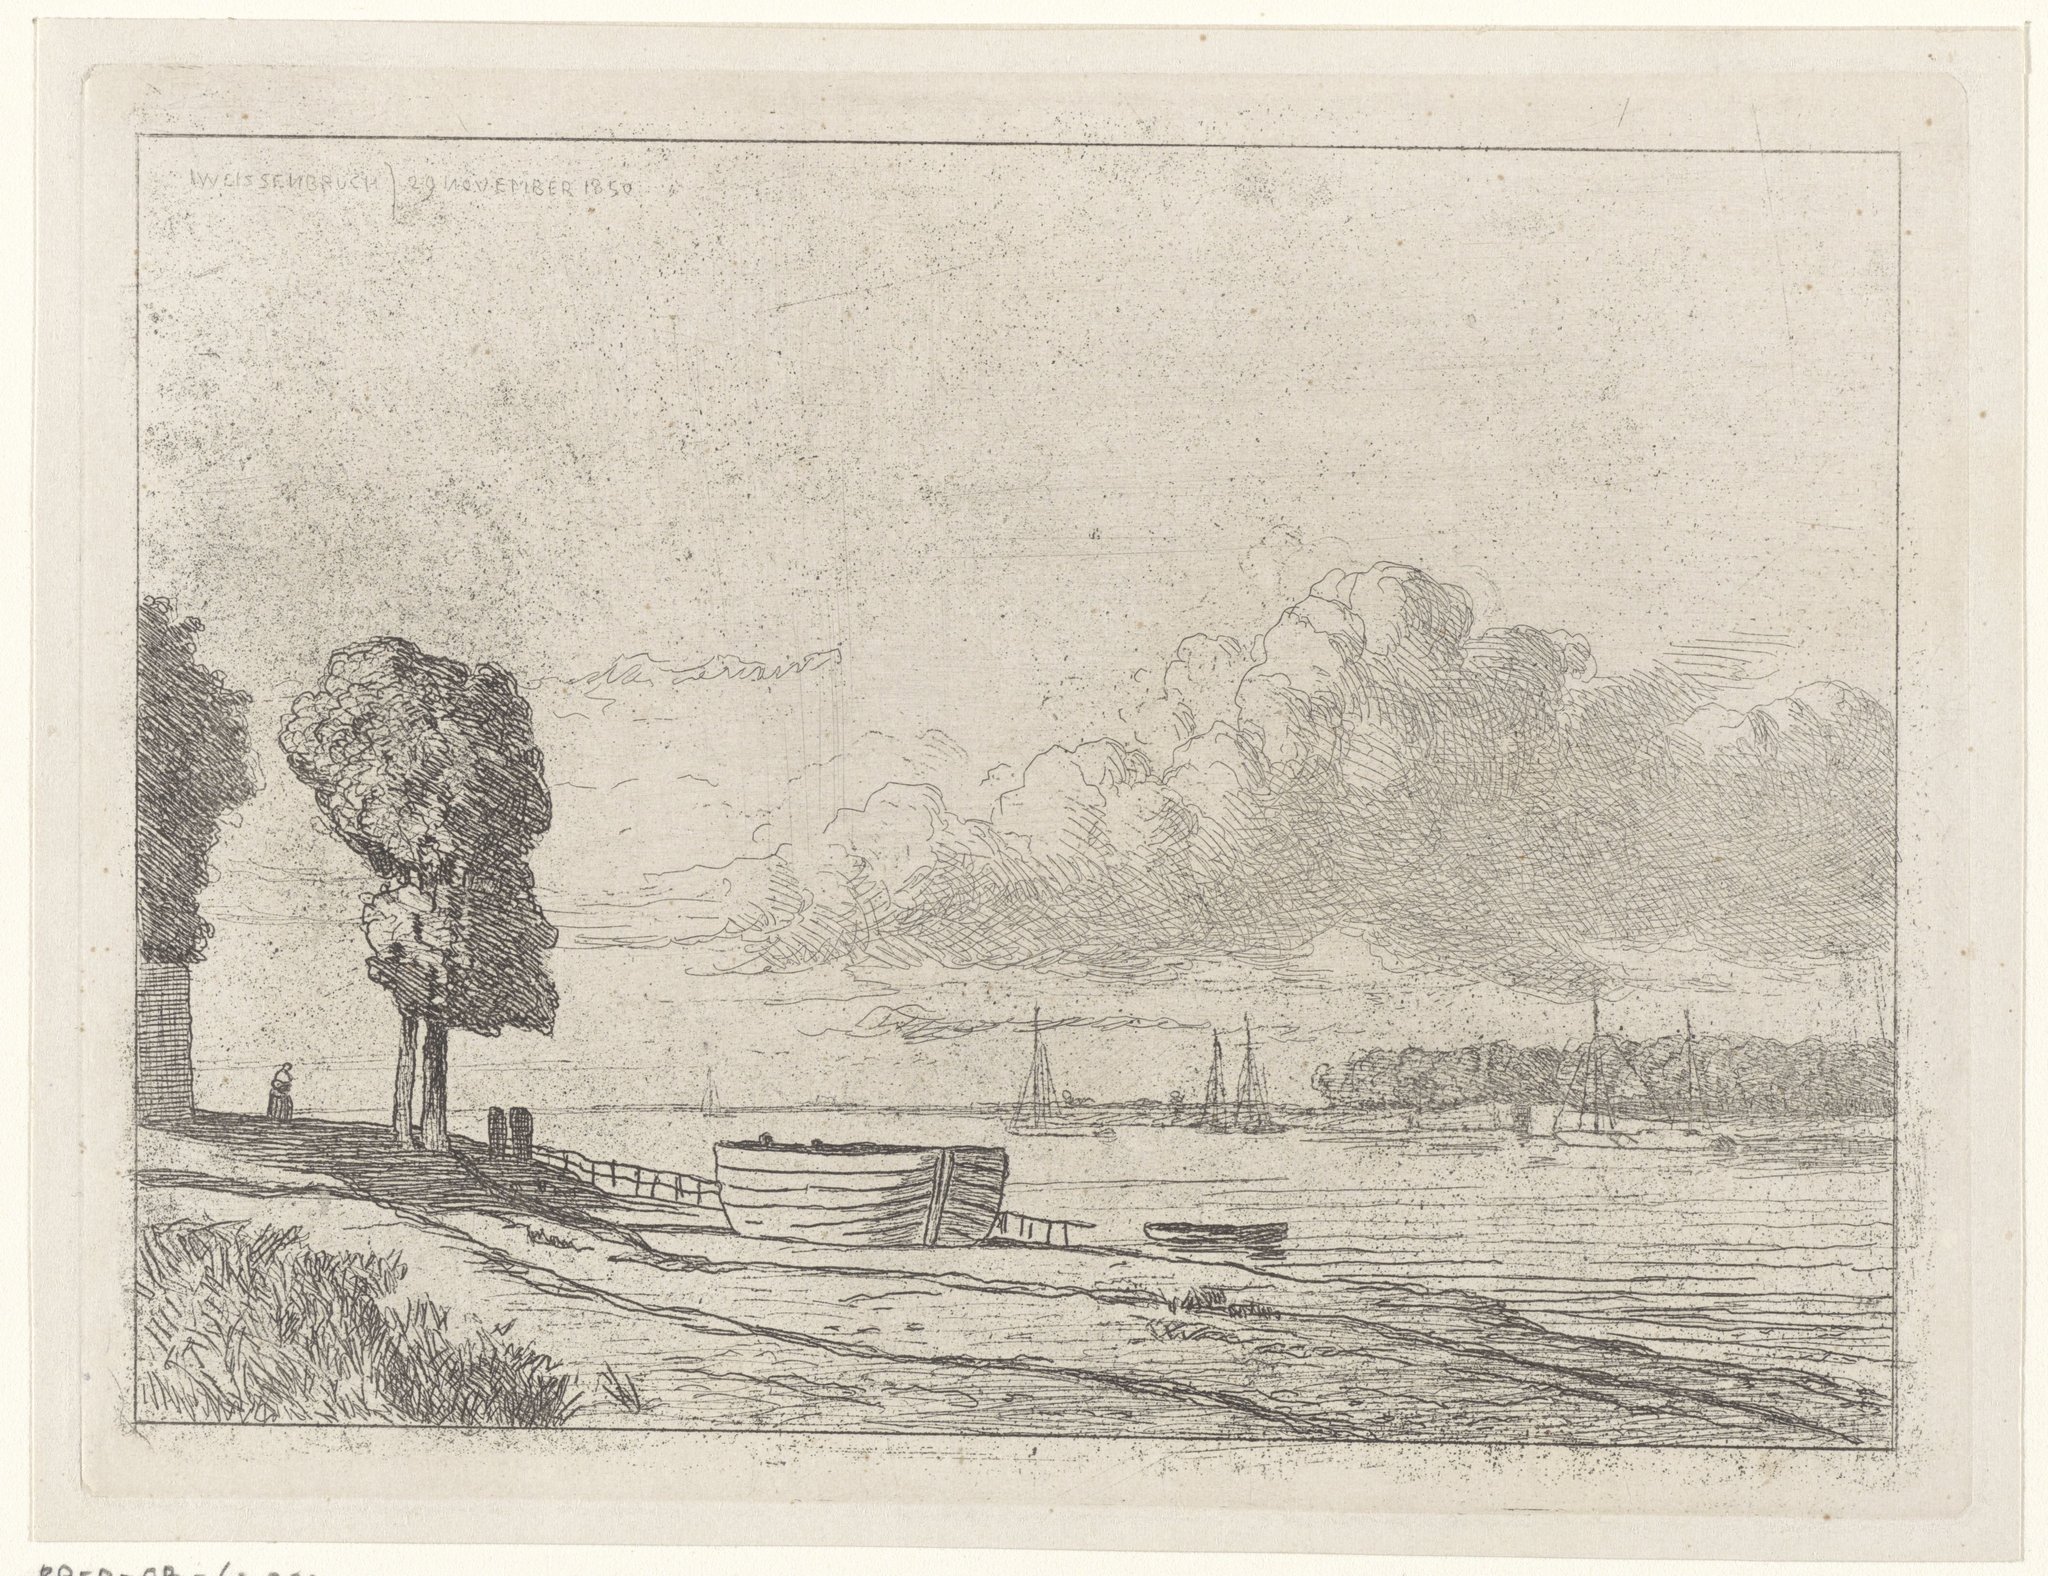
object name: print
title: Gezicht op de rivier de Lek bij Vreeswijk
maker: jan weissenbruch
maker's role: painter, print maker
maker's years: 1822-1880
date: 1850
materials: paper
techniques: etching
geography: culemborg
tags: trees, sailing-ship, sailing-boat, landscapes, river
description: Op de rivier zijn enkele zeilschepen te zien. Links ligt een boot op de kant. Op het pad ernaast is een figuur weergegeven.